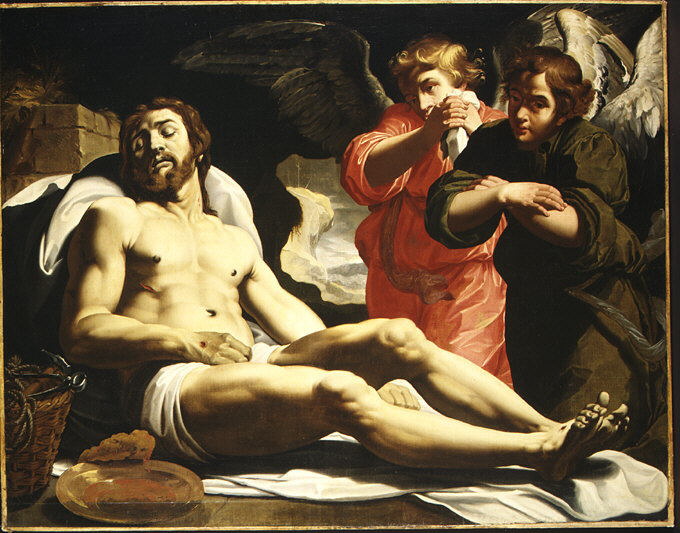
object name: painting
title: The Dead Christ in the Tomb with Two Angels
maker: abraham janssen van nuyssen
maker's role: artist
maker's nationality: flemish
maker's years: 1575-1632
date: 1610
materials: canvas, oil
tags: angels,christ,death